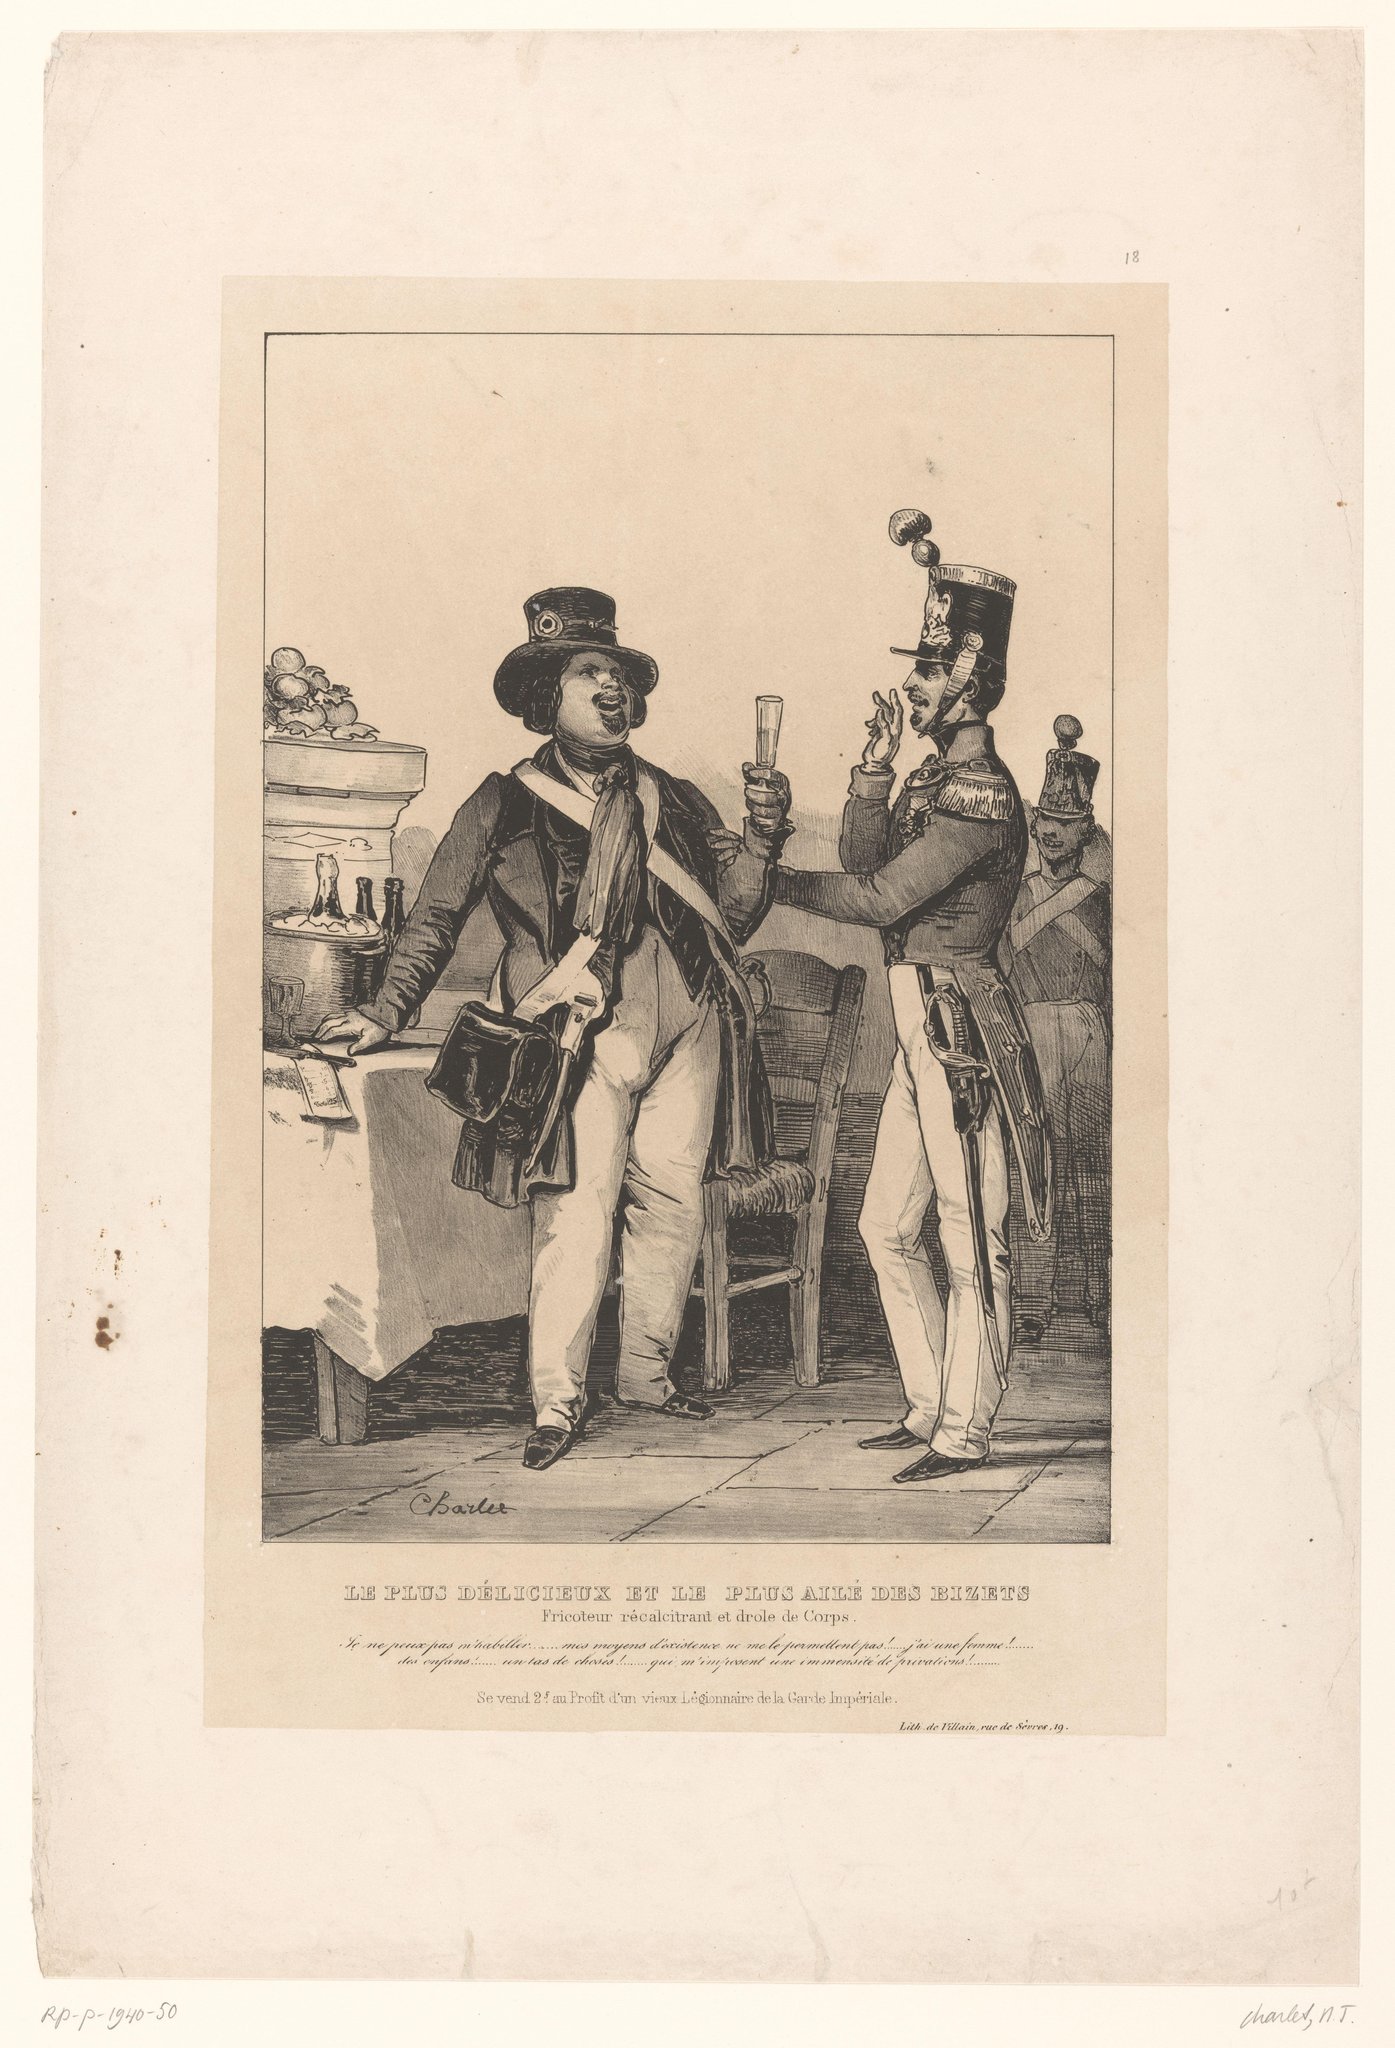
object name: cartoon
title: Schetsen in mezzotint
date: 1840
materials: paper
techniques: tone lithography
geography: paris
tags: canteen ~ the soldier off duty, officer, restaurant, glutton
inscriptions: number: ‘18’, collector's mark: Lugt 2166, collector's mark: Lugt 2760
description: De officier berispt de man, die zich tegoed doet aan het voedsel en de wijn op tafel, omdat hij zijn uniform niet draagt. De man verontschuldigt zich door te zeggen dat hij zich geen uniform kan veroorloven vanwege zijn vrouw en kinderen.